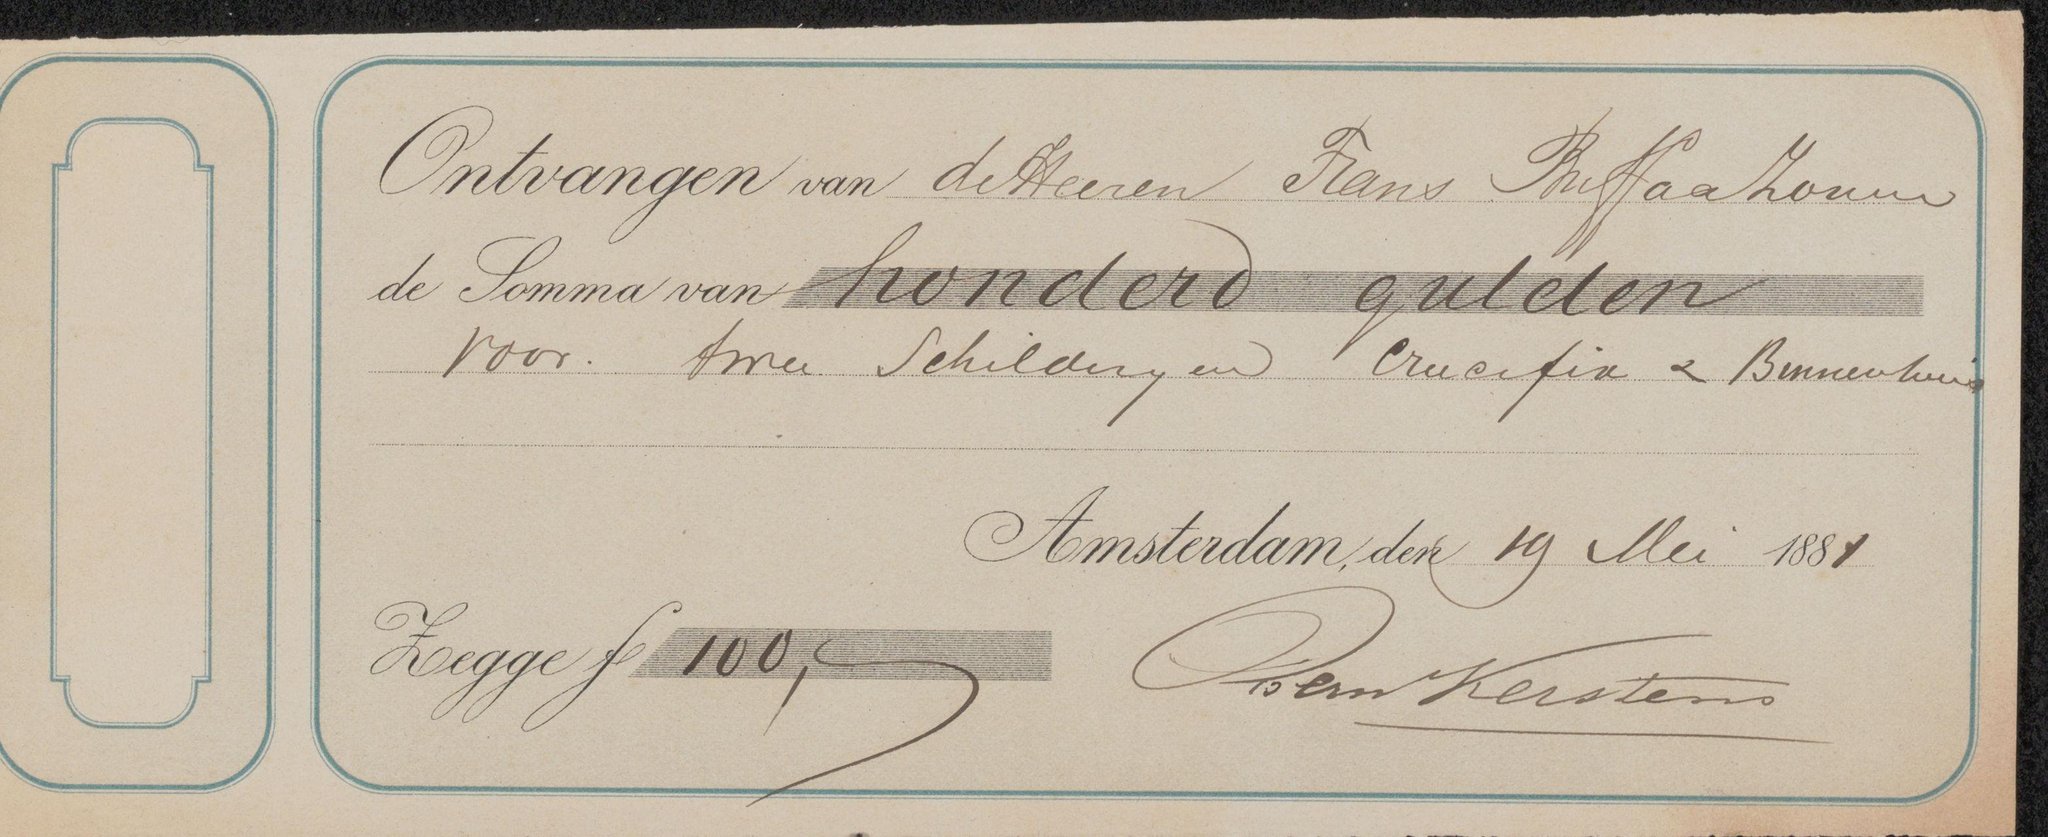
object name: ontvangstbewijs, kwitantie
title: Kwitantie voor onbekend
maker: Anonymous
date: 1881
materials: ink, paper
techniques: pen, printing, writing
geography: amsterdam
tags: painting (including book-illumination, miniature-painting), money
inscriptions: collector's mark: Lugt 2233